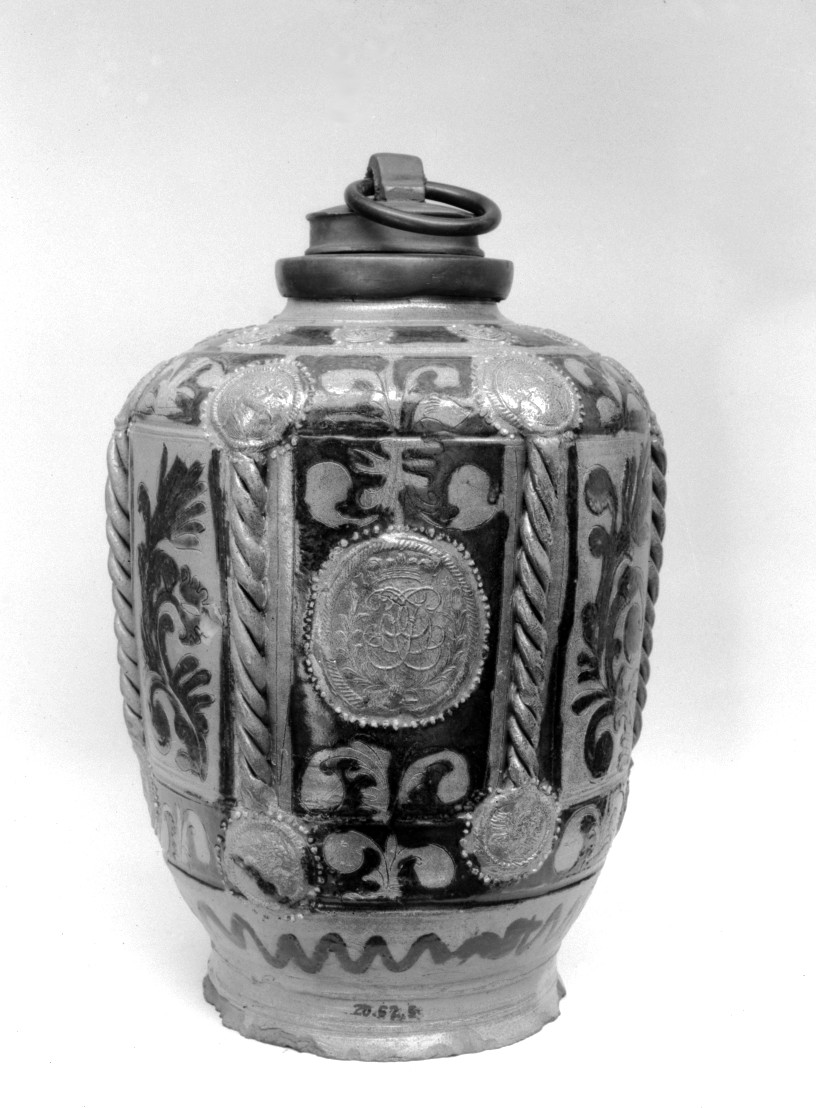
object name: jar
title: Screw-top jar (Schraubflasche)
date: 1767-1800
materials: stoneware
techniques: salt glaze